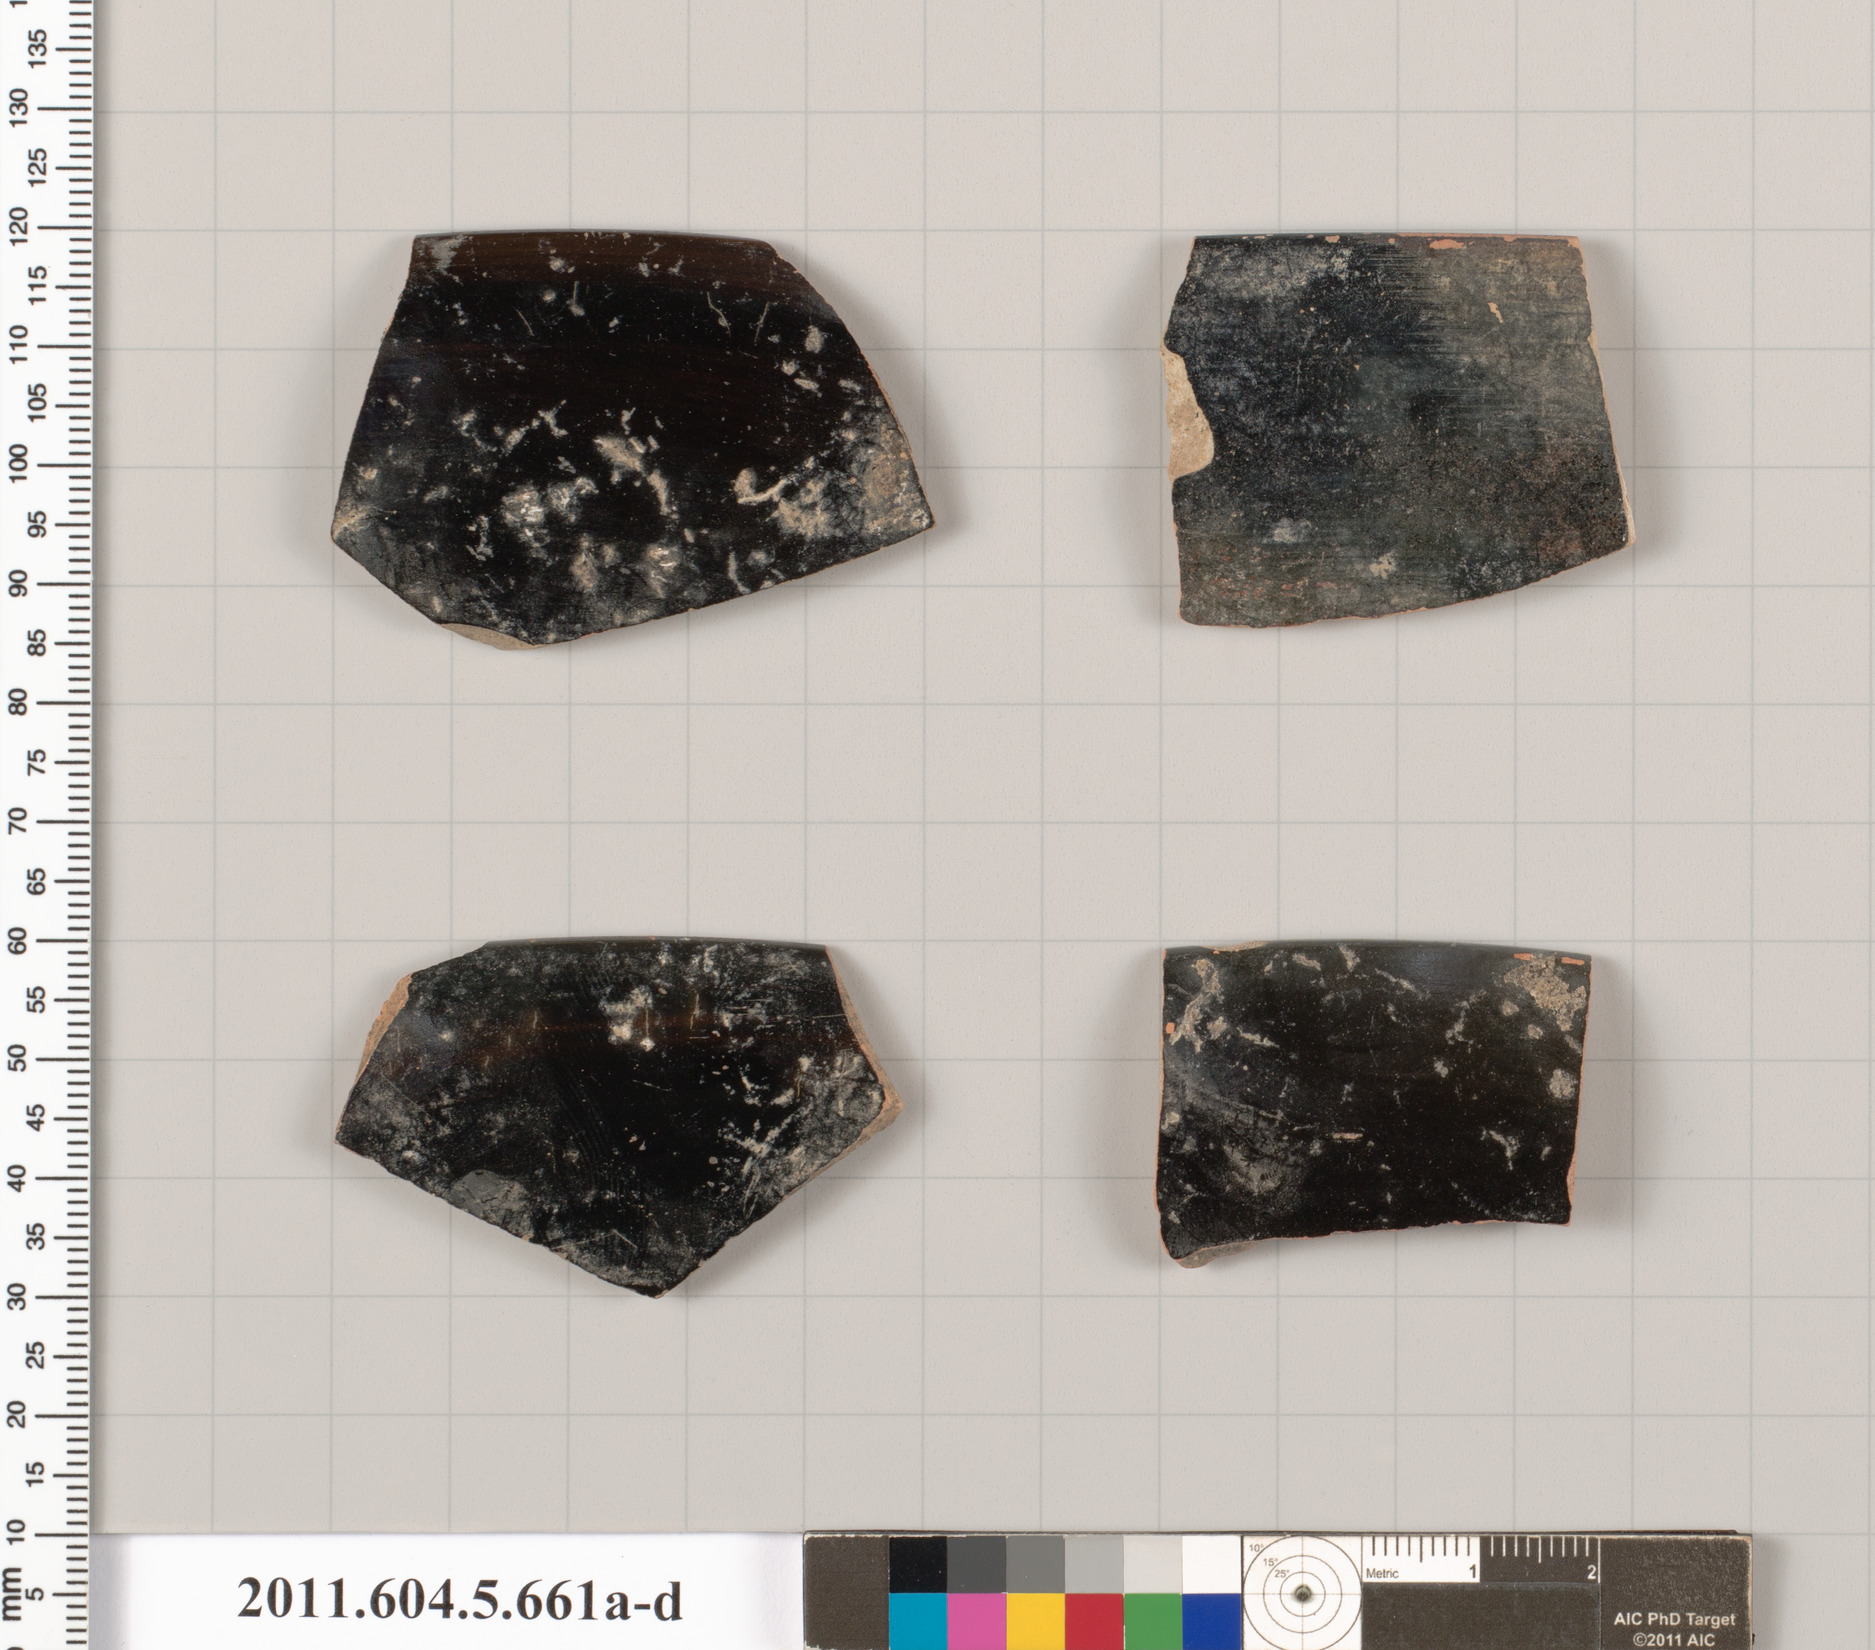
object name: kylix fragment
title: Terracotta rim fragments of kylikes (drinking cups)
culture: greek, attic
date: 600-401 BCE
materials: terracotta